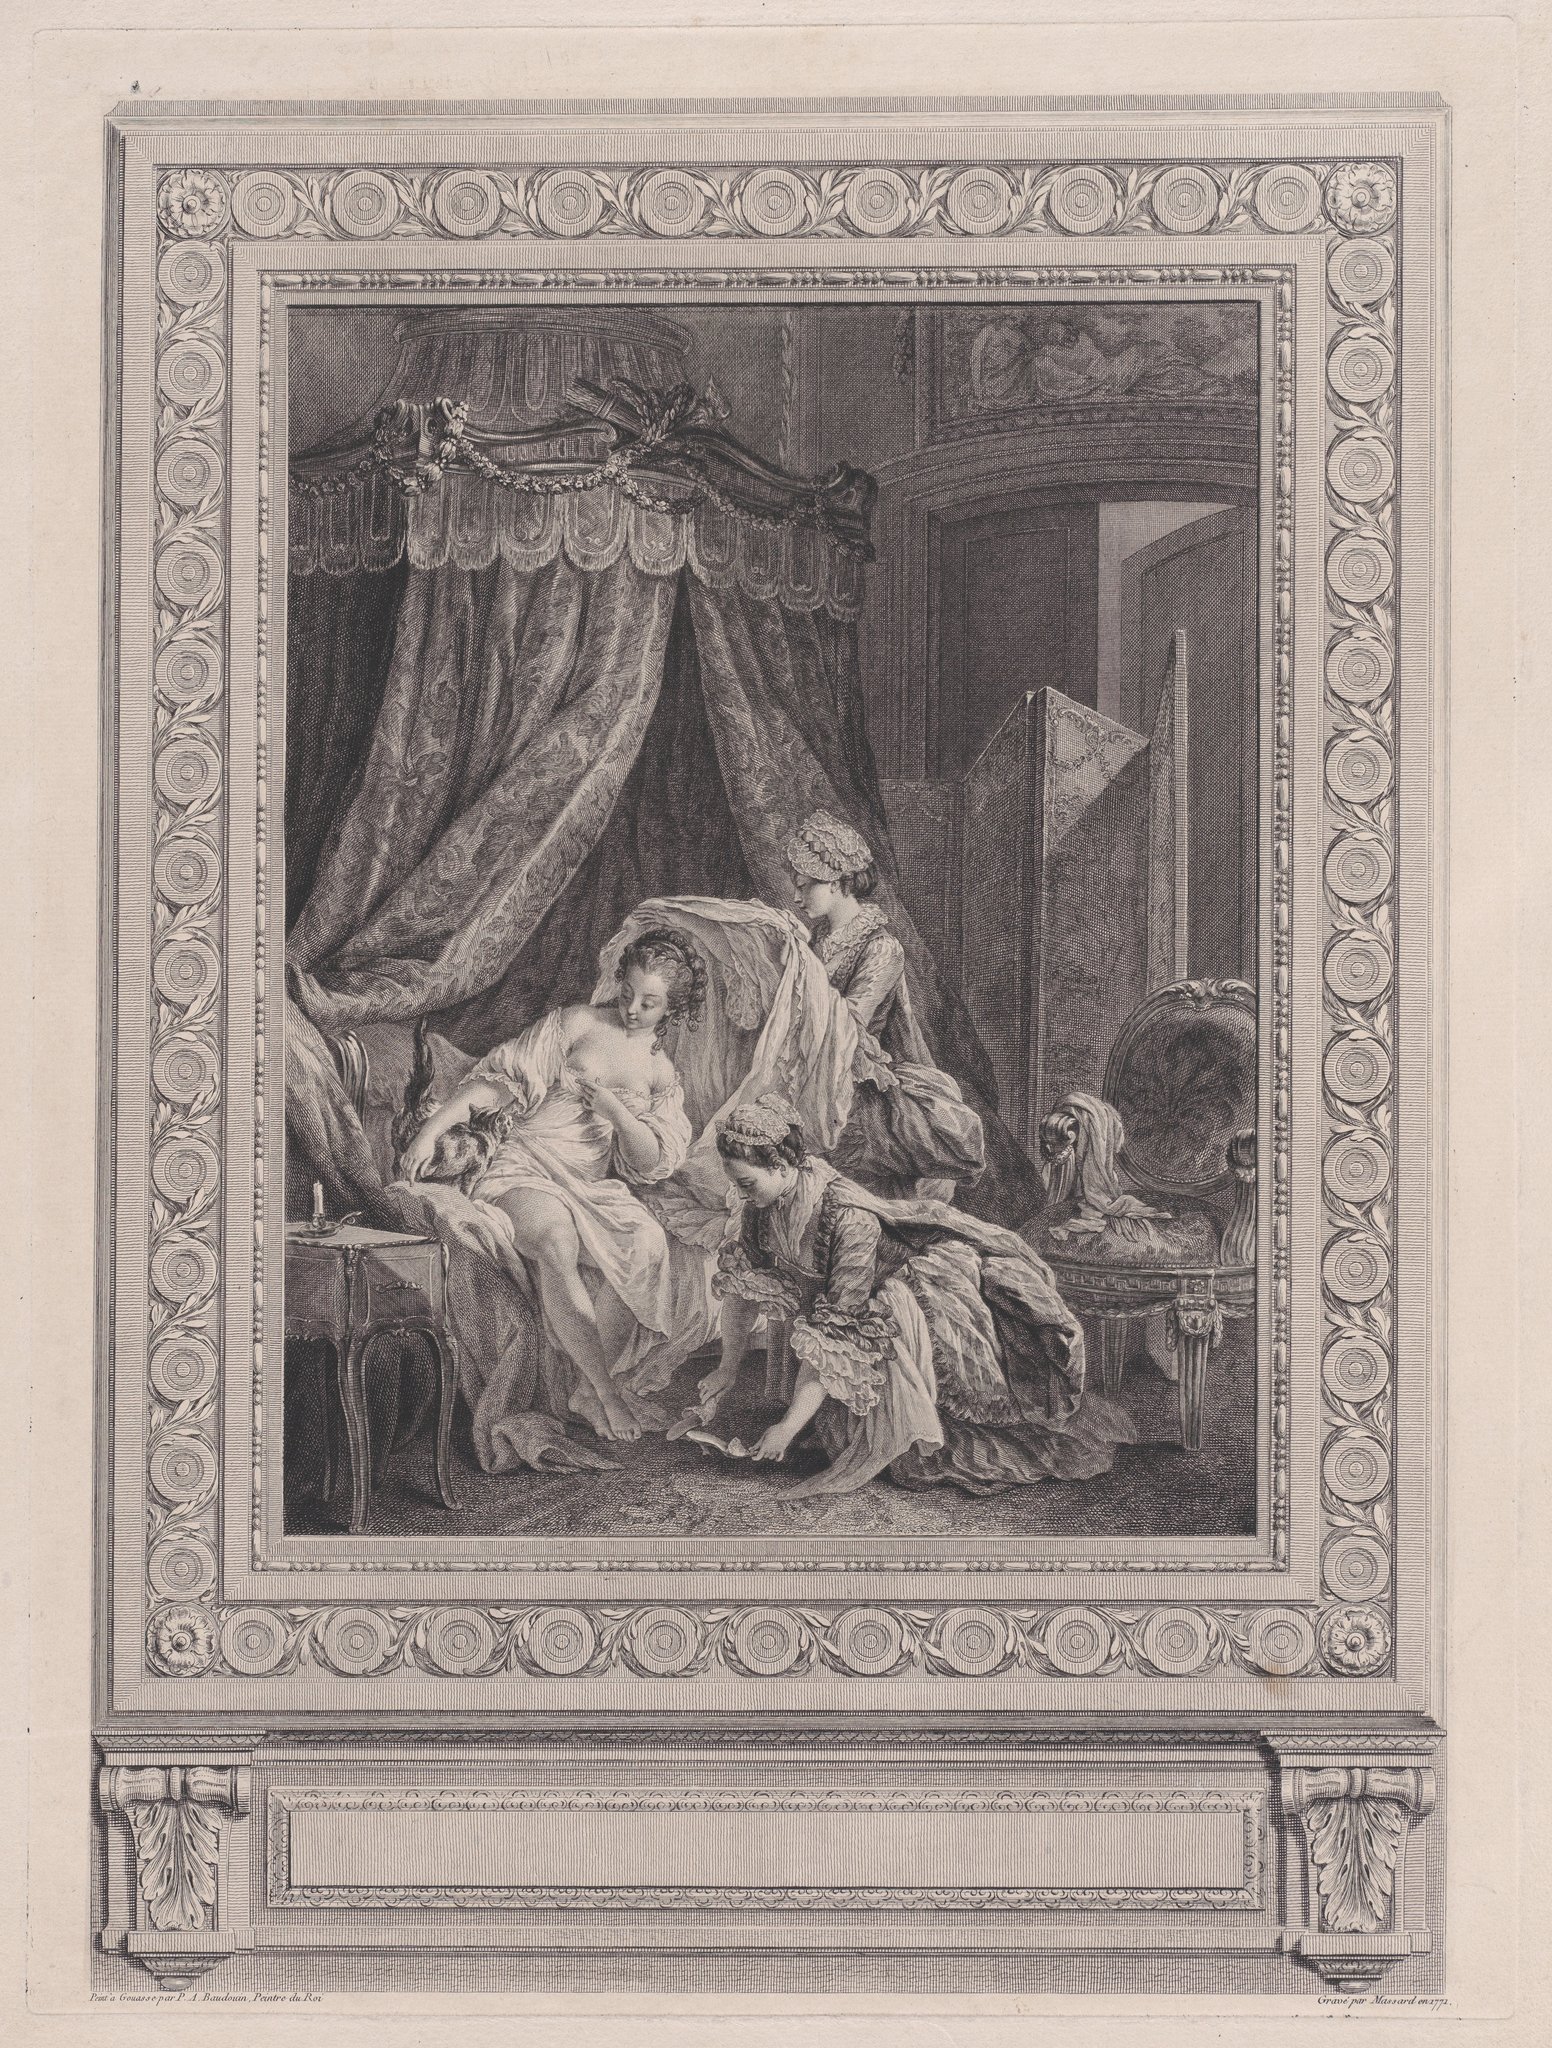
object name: print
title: Le Lever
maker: pierre antoine baudouin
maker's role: artist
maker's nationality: french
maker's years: 1723-1769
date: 1771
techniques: engraving